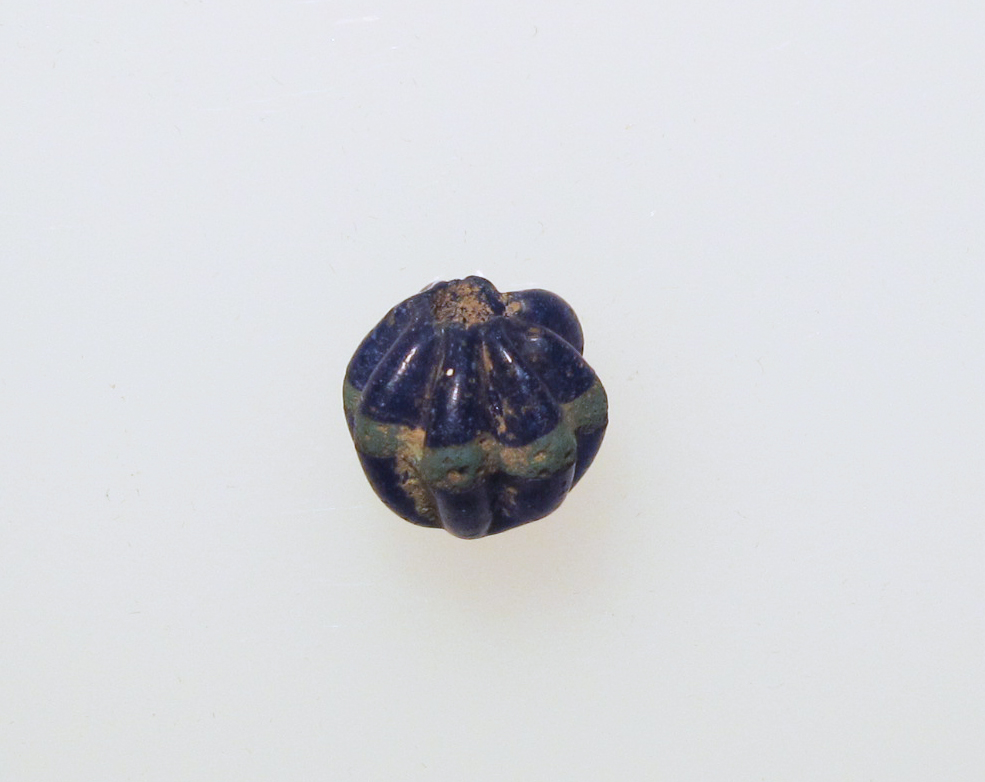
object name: bead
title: Glass bead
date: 7000 BCE-330 CE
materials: glass